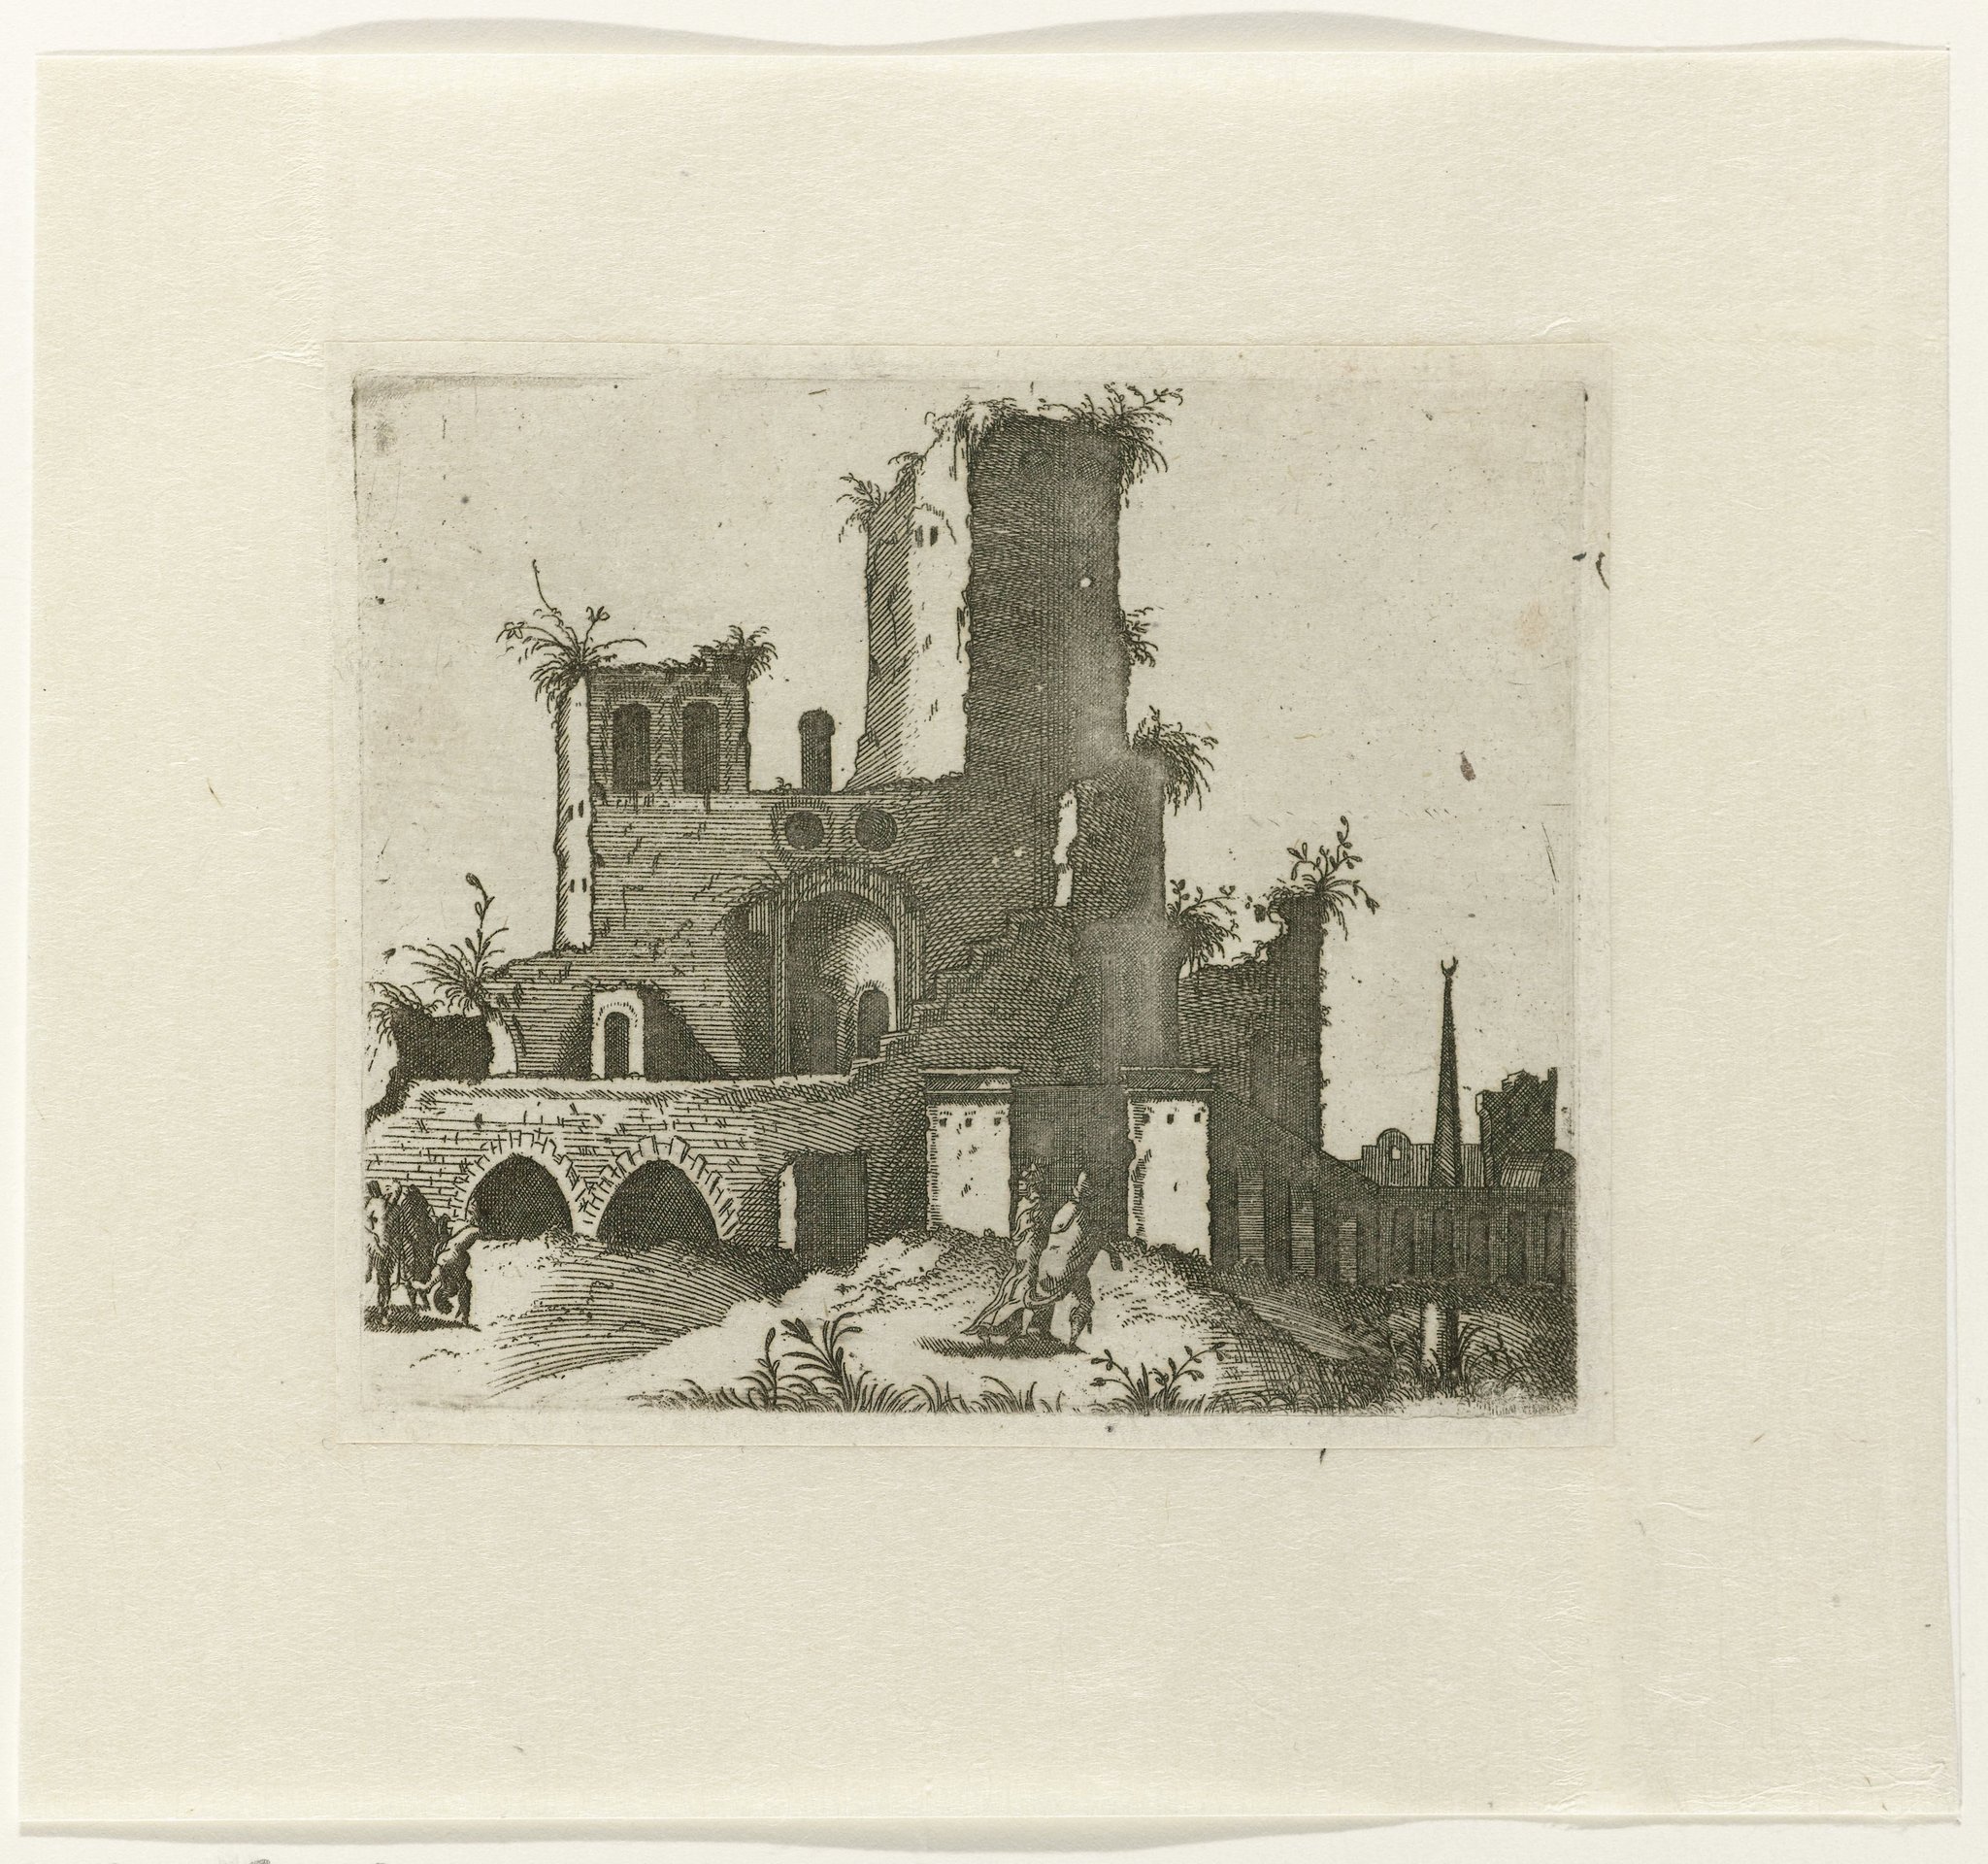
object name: print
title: Ruinarum variarum fabricarum delineationes pictoribus caeterisque id genus artificibus multum utiles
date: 1560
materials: paper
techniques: engraving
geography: antwerp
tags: ruin of a building ~ architecture, landscape with ruins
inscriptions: collector's mark: Lugt 2228, collector's mark: Lugt 2760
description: Een ruïne met een rechthoekige toren. Op de voorgrond figuren.